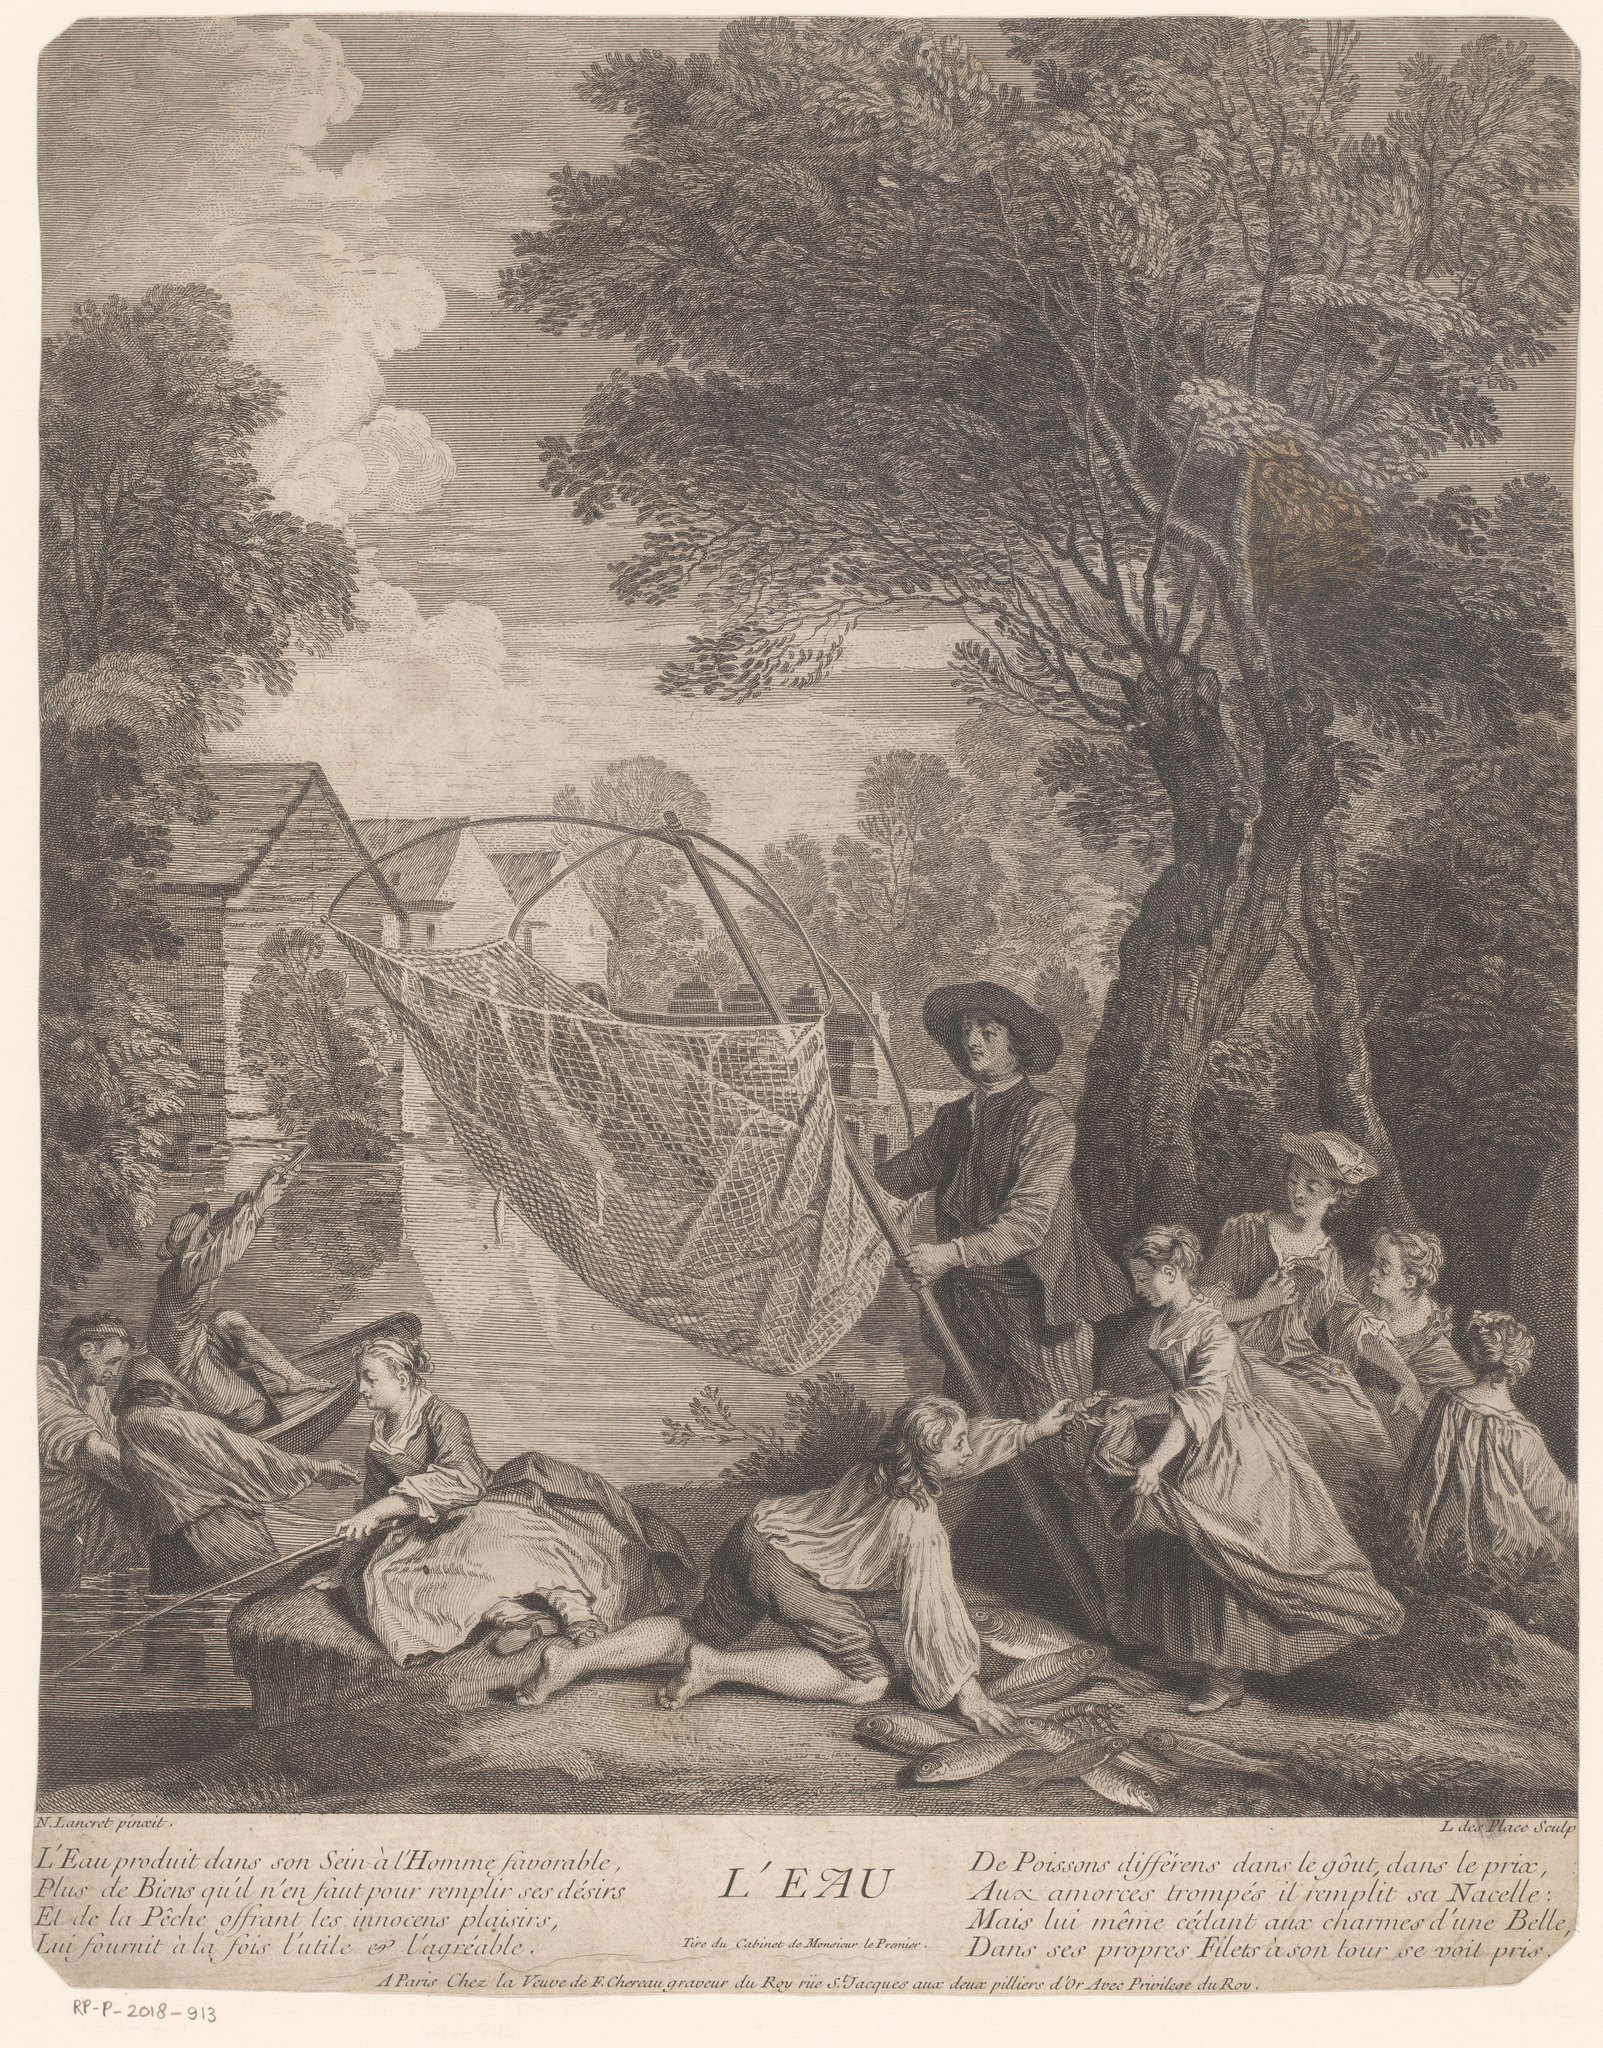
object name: print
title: Water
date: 1732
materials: paper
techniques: engraving, etching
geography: france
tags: fishing net, water (one of the four elements), fishing (sports)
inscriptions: collector's mark: Lugt 2228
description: Gezelschap aan de oever van een rivier. Een man houdt een schepnet in de hand. Links een zittende vrouw met hengel.